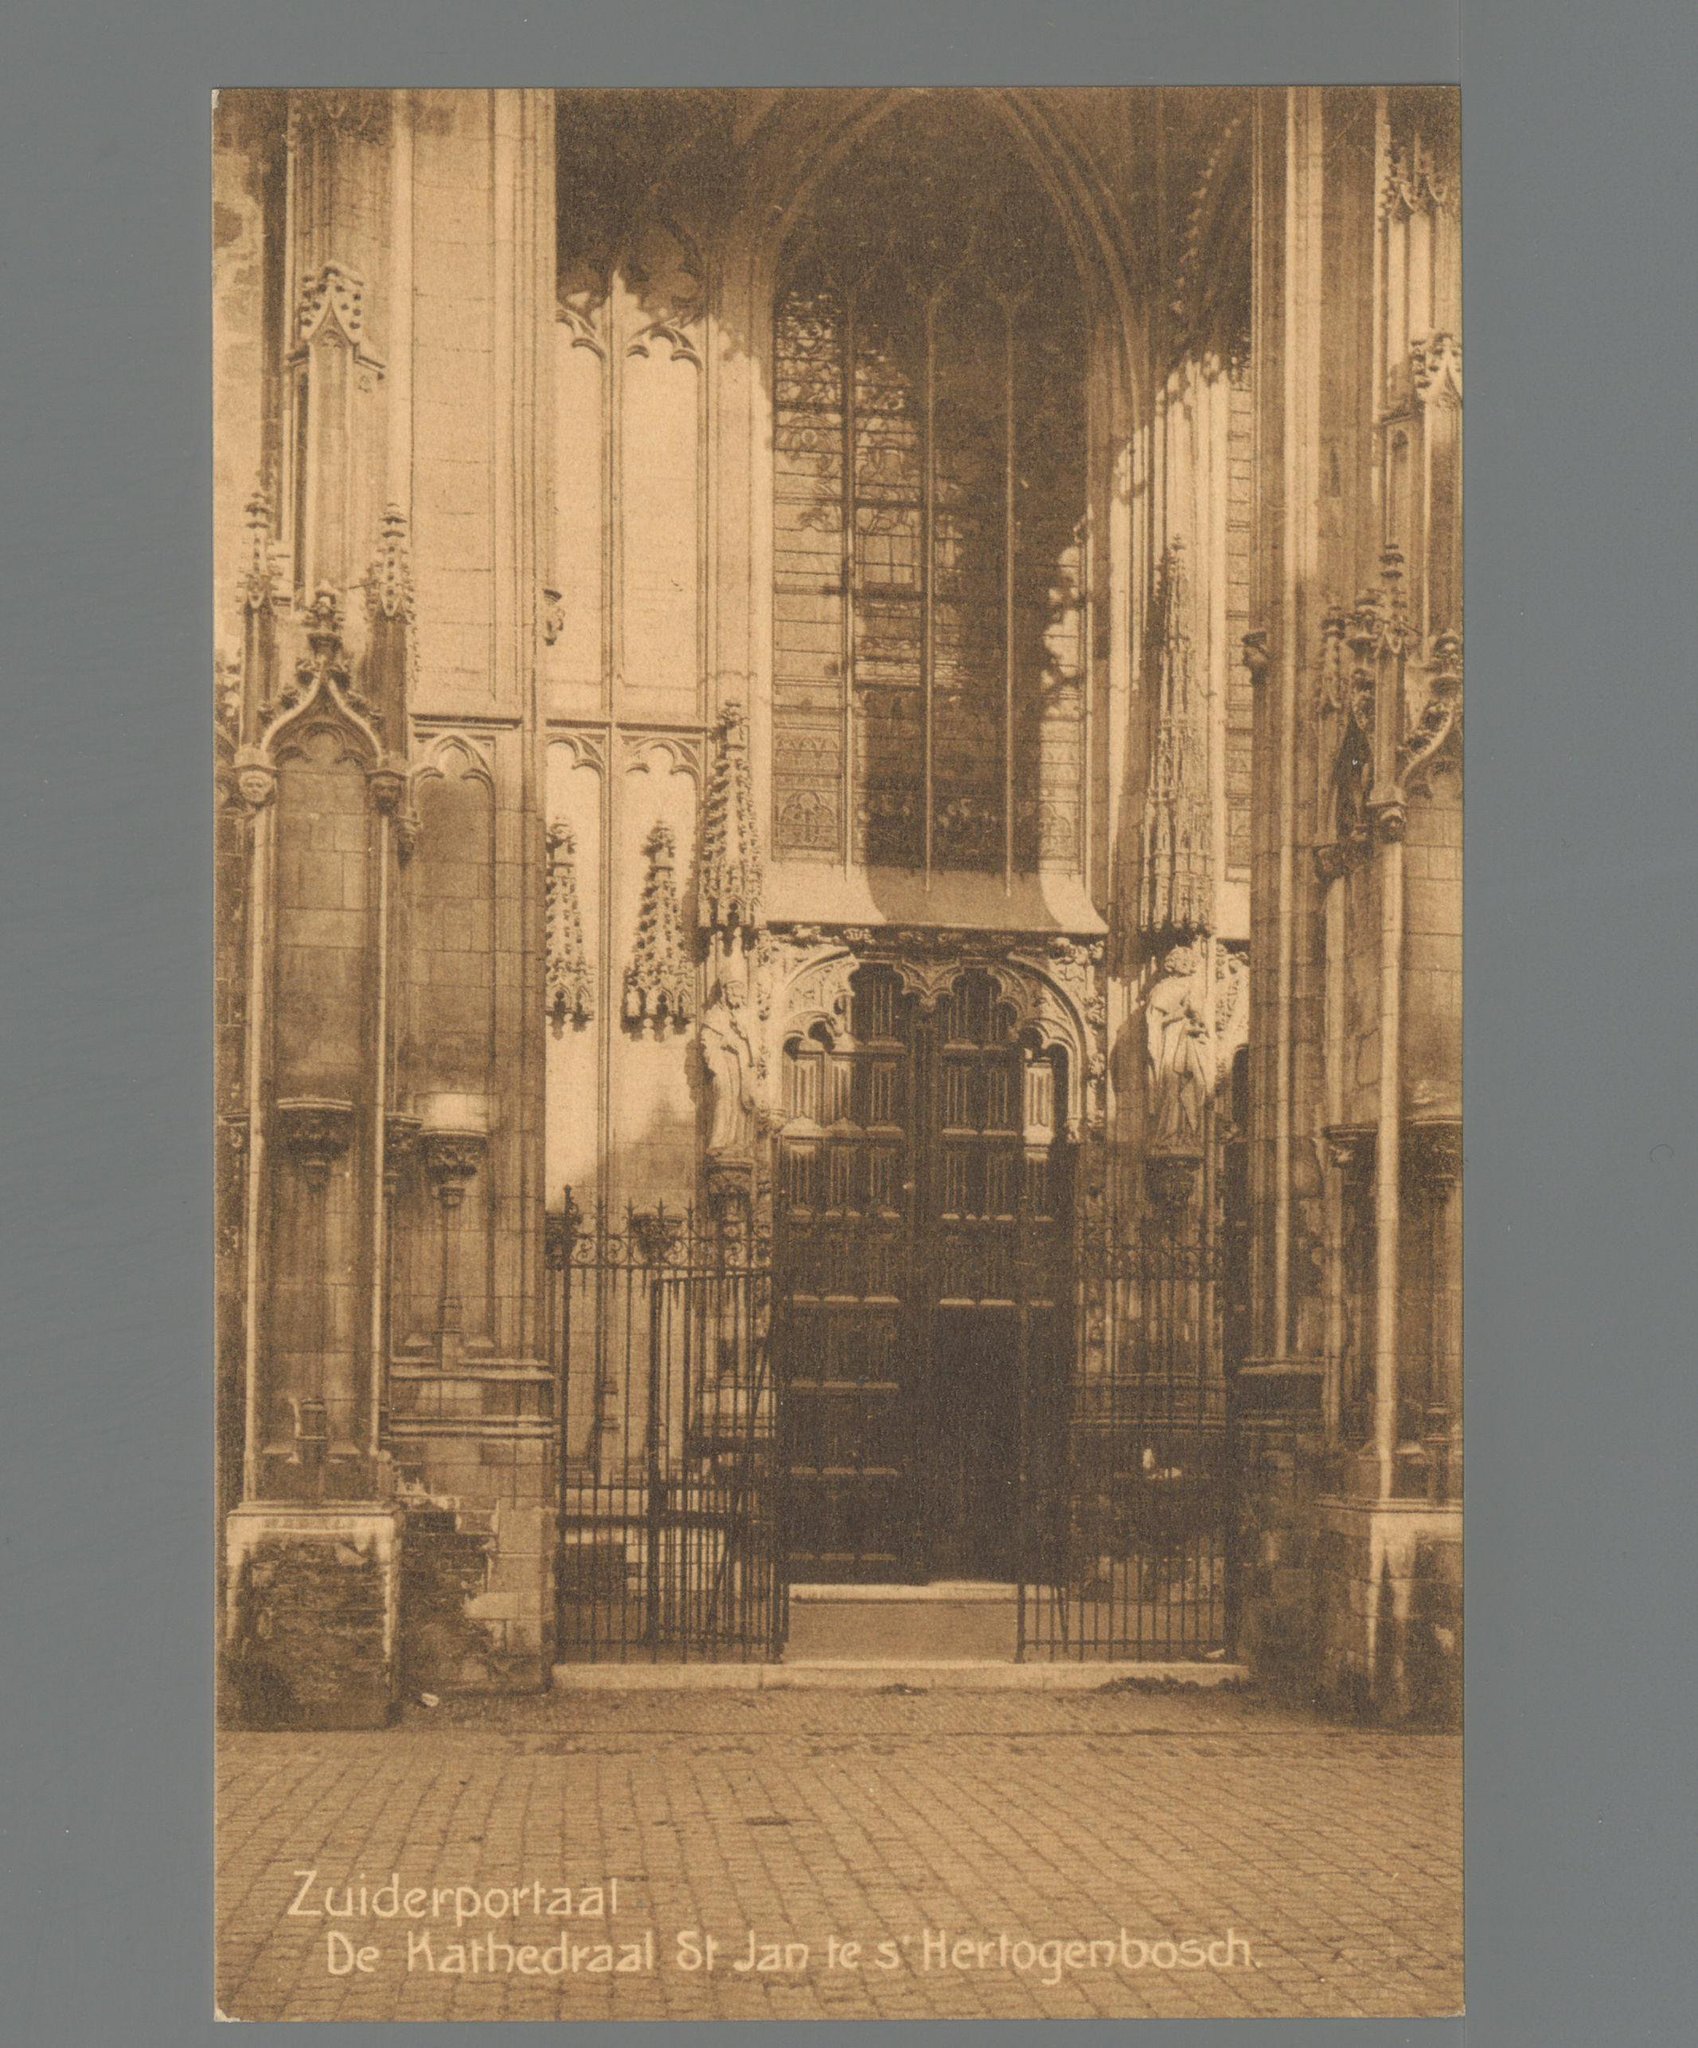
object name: photomechanical print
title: De Kathedraal St Jan te s' Hertogenbosch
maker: Anonymous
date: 1905-1930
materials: cardboard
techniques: photograph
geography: den bosch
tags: parts of church exterior and annexes: portal